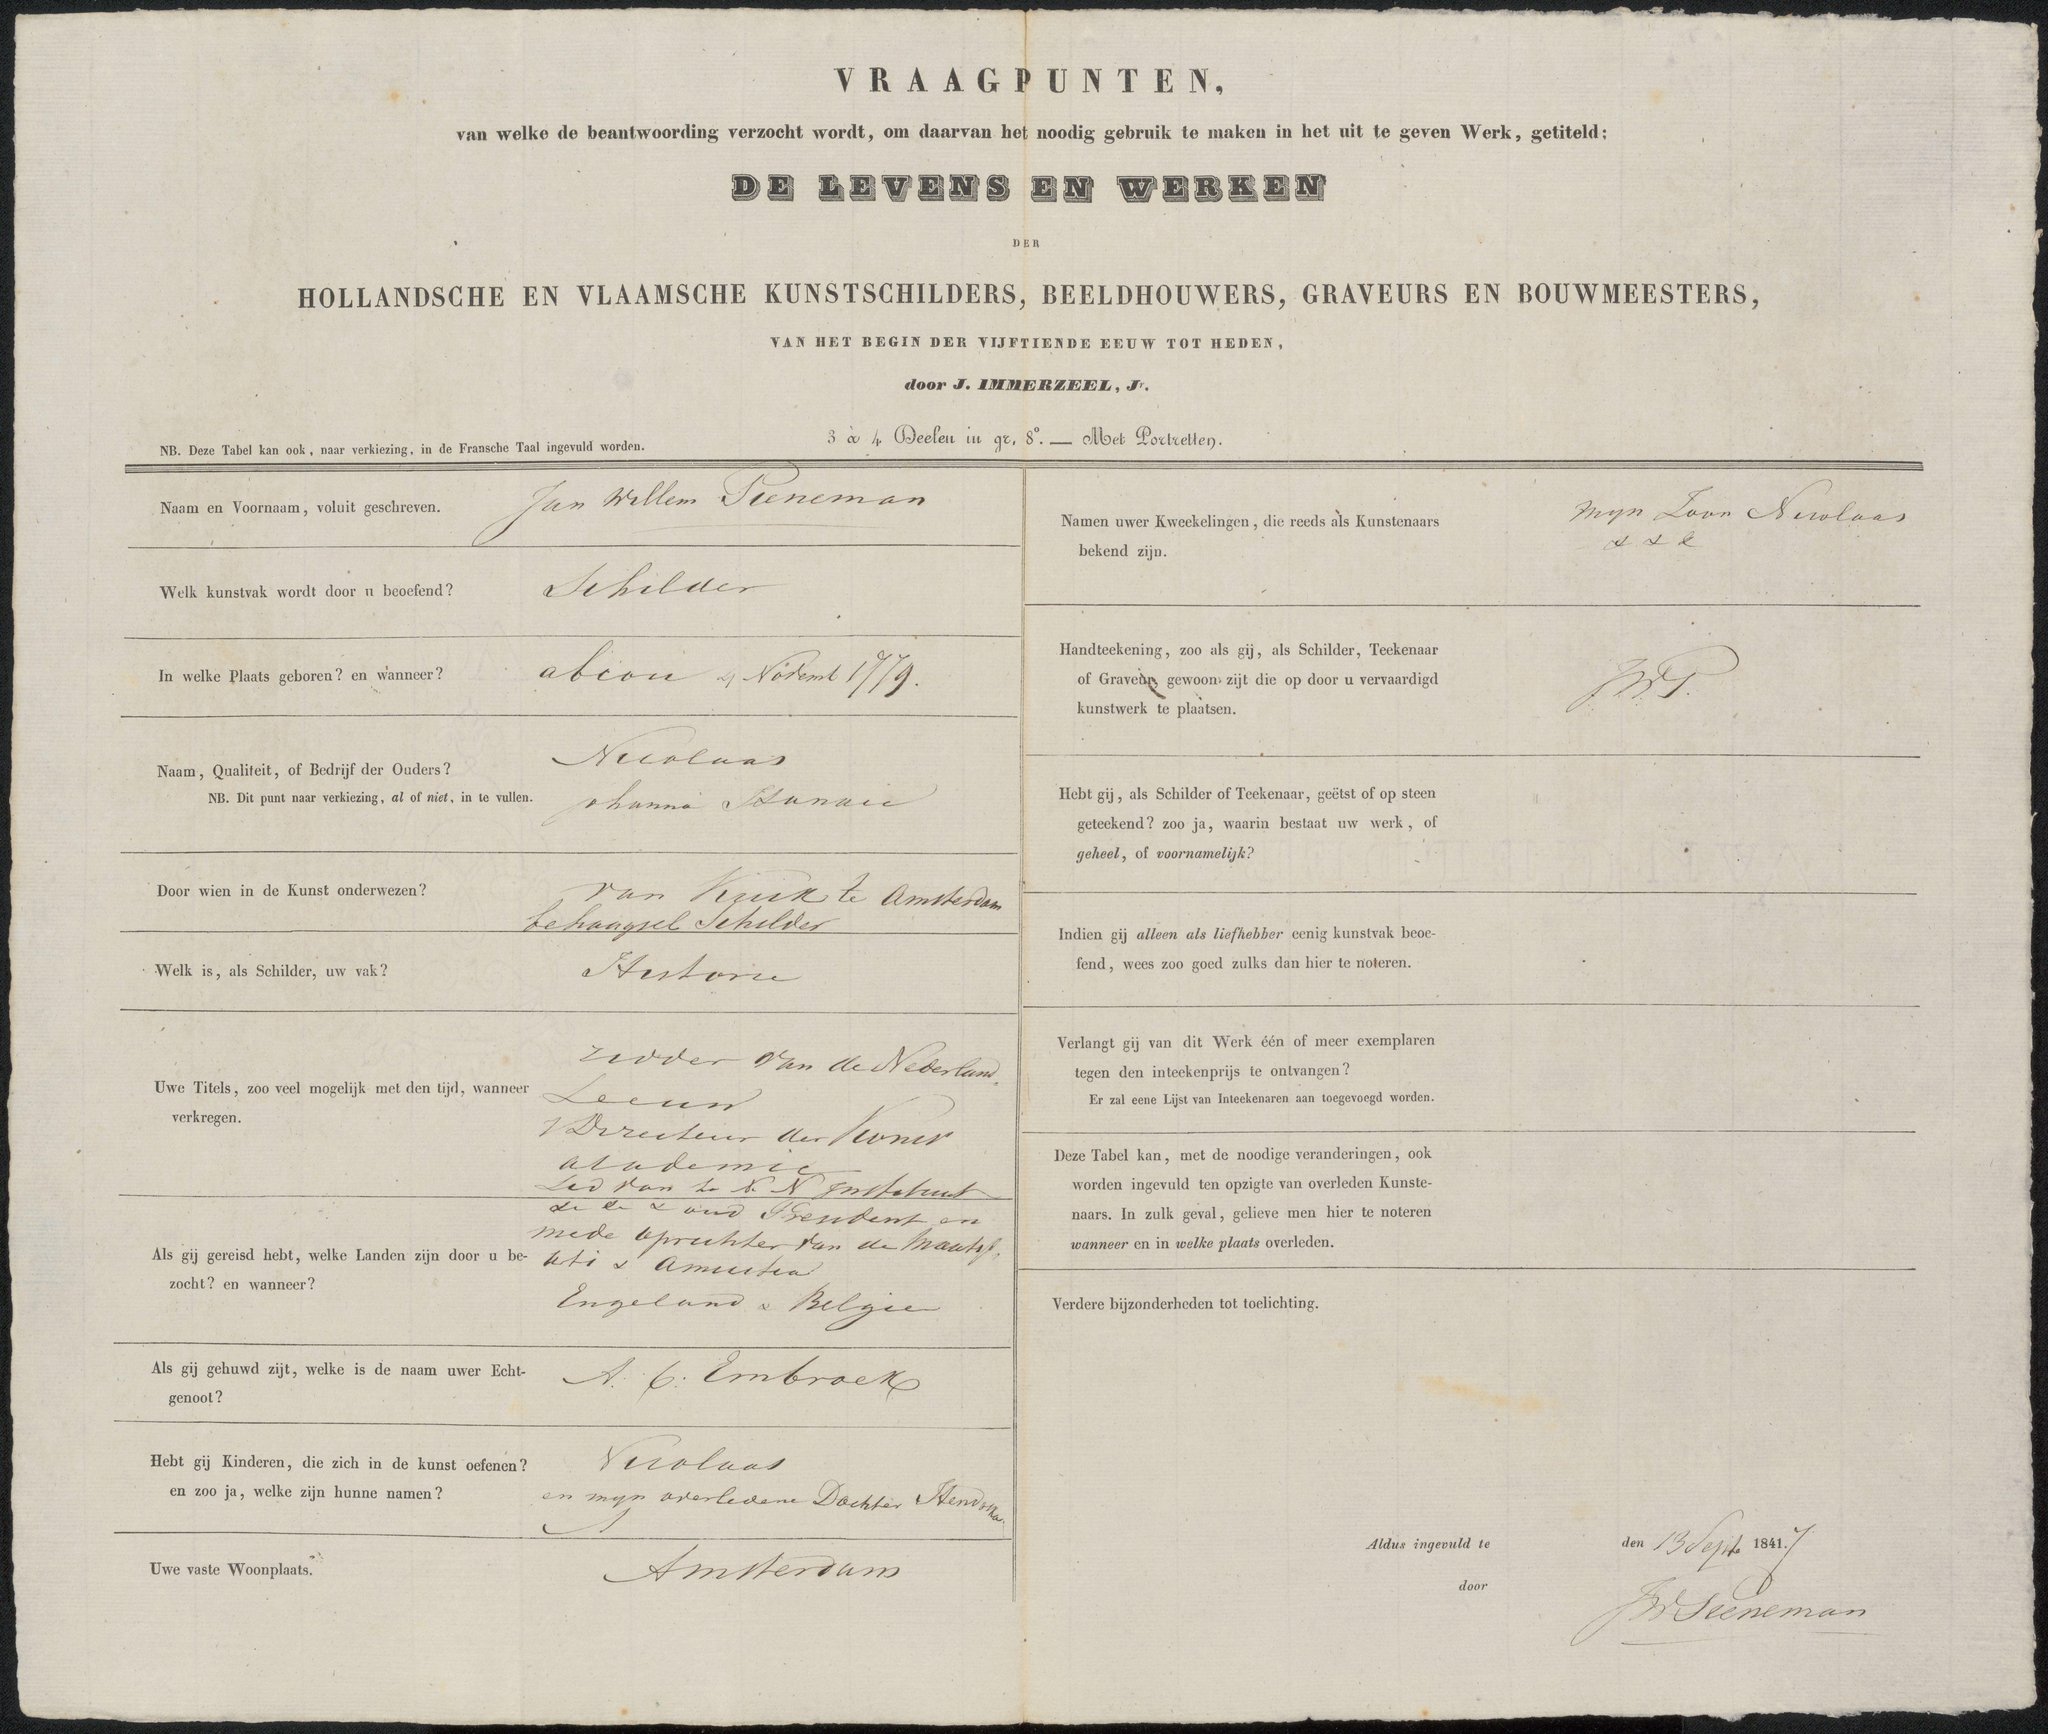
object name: manuscript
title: Enquêteformulier ingevuld door Jan Willem Pieneman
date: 1847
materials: ink, paper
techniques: pen, printing, writing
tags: abcoude, amsterdam, painter, print maker, draughtsman, jan willem pieneman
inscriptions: inscription: ‘Vraagpunten,/ van welke de beantwoording verzocht wordt, om daarvan het noodig gebruik te maken in het uit te geven Werk, getiteld: De levens en werken/ der Hollandsche en Vlaamsche kunstschilders, beeldhouwers,/ graveurs en bouwmeesters, van het begin der vijftiende eeuw tot heden/ door J. Immerzeel, Jr.’, watermark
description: Opgenomen in: Immerzeel, J. Jr., De levens en werken der Hollandsche en Vlaamsche kunstschilders, beeldhouwers, graveurs en bouwmeesters, van het begin der vijftiende eeuw tot heden, Amsterdam: J.C. van Kesteren, 1842-1843.